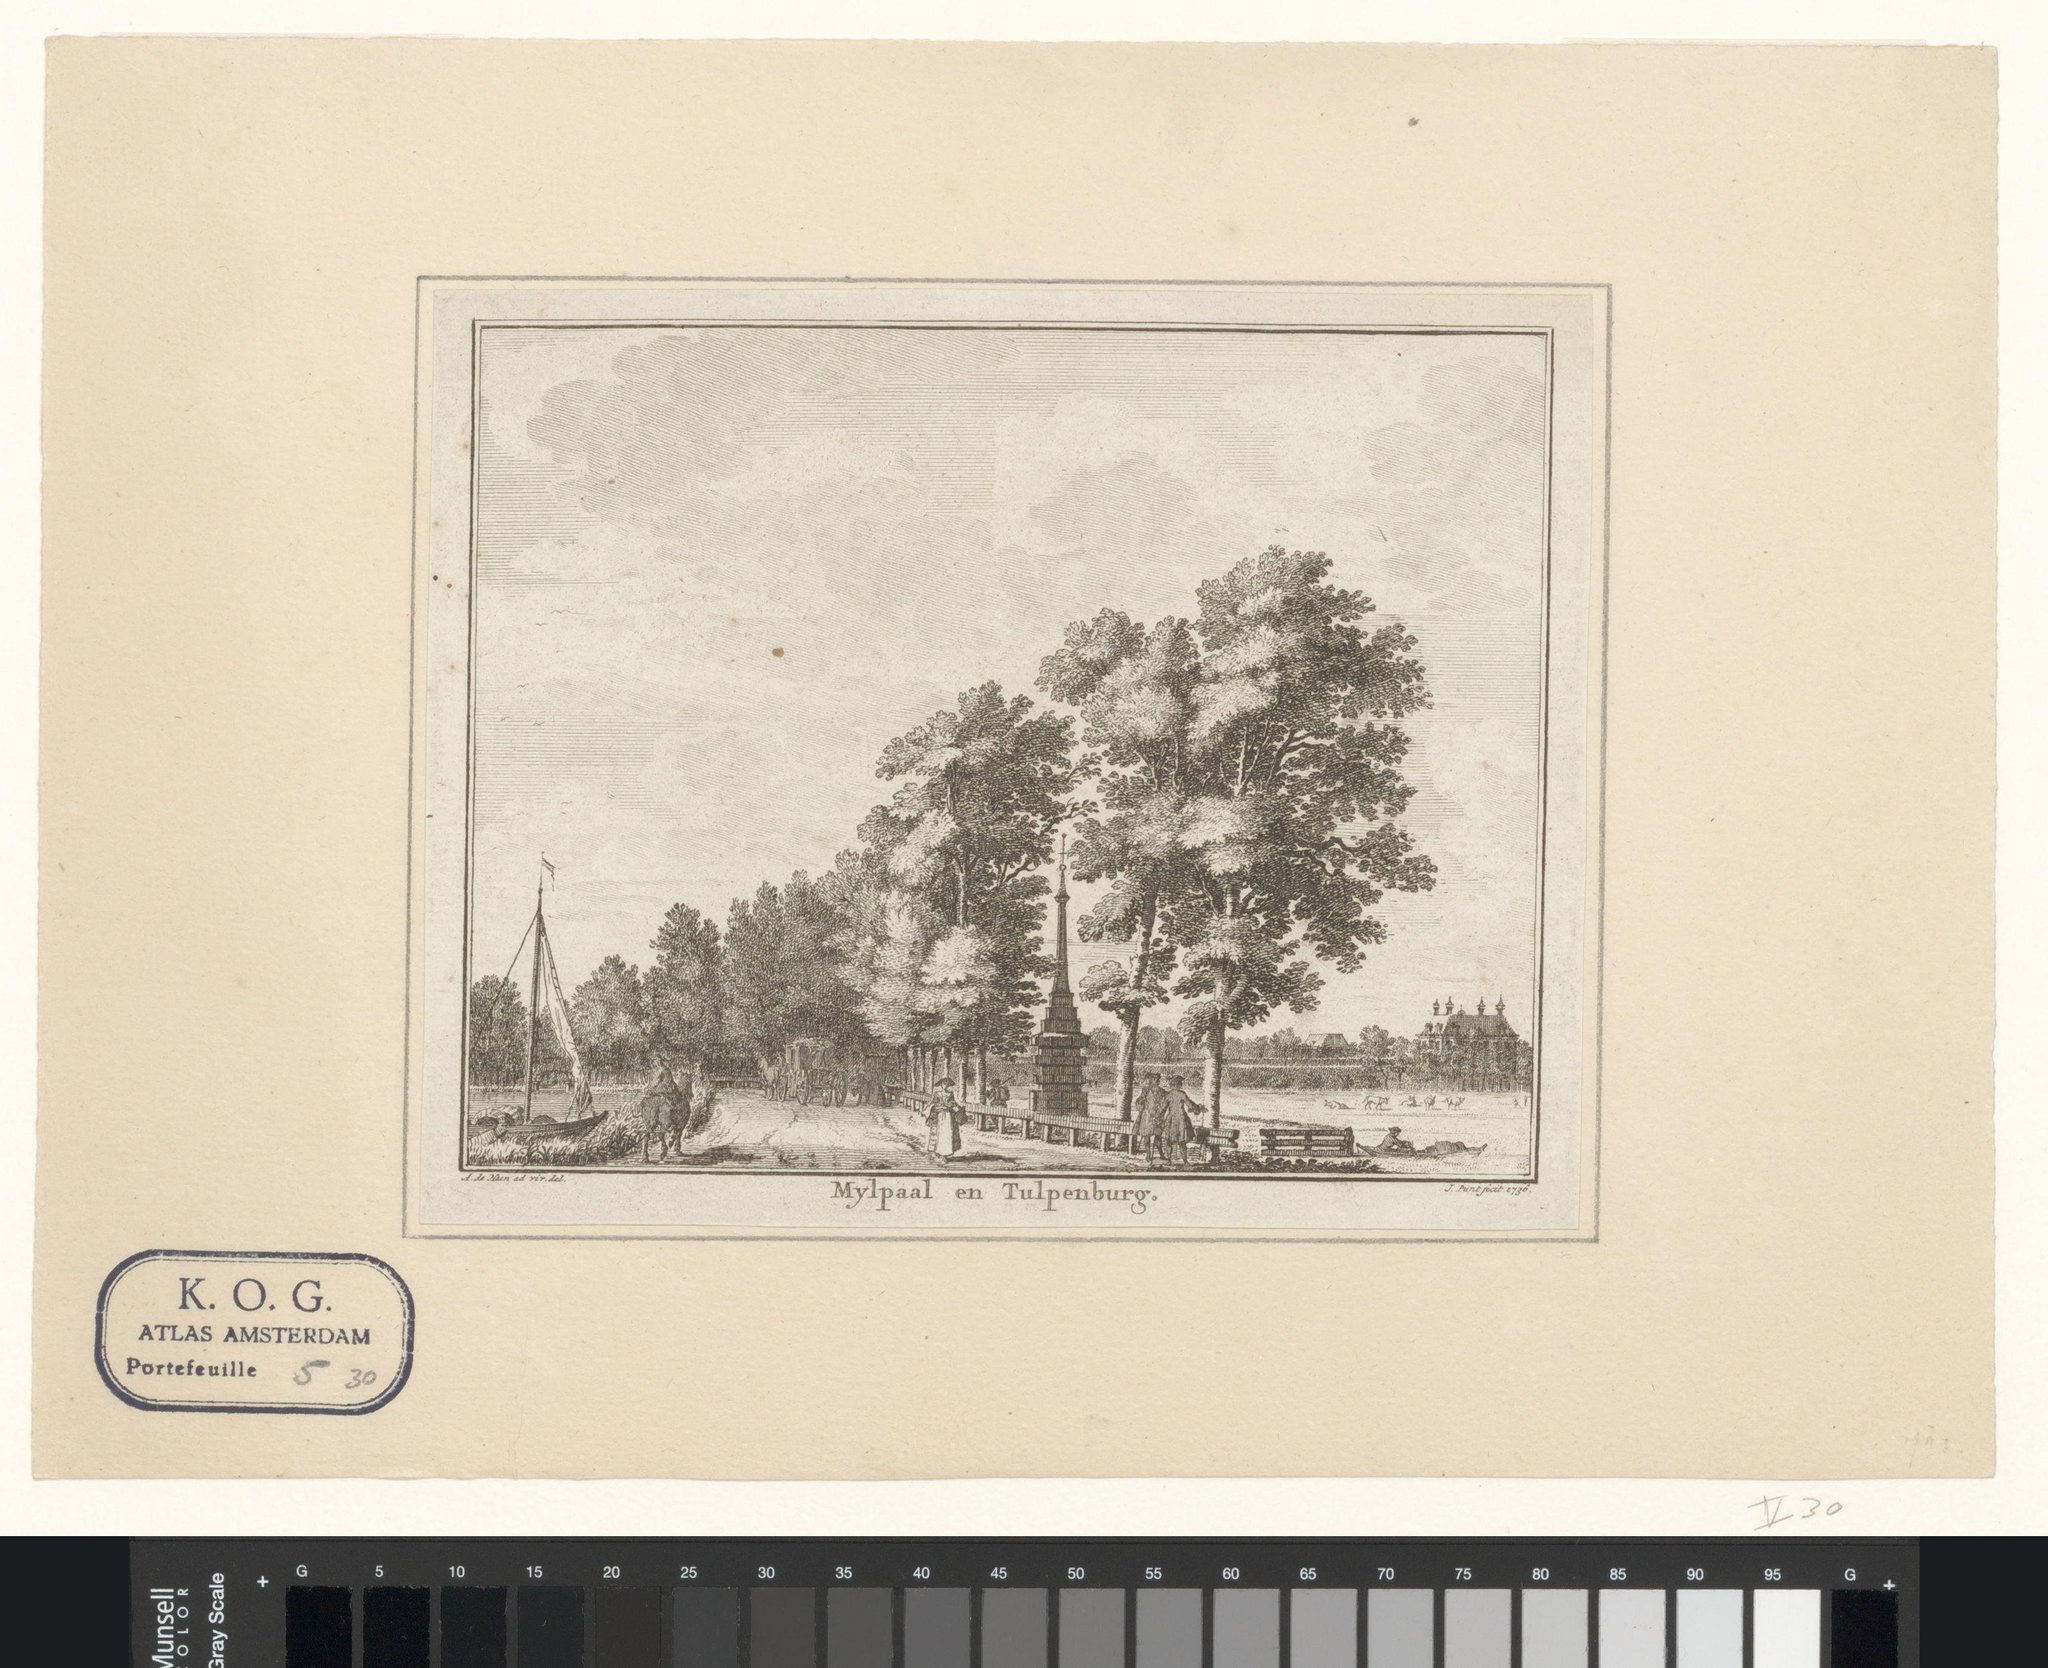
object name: print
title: Mylpaal en Tulpenburg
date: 1736-1773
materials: paper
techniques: engraving, etching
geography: amstelveen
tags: city-view in general; 'veduta', river, rural housing, e.g. country-house, villa, cottage, milestone, boat propelled by man or animal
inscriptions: collector's mark: ‘5 30’ Lugt 1641b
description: Prent ook gebruikt in: Schoemaker, Gerrit ed. Daniel Willinks Amstellandsche Arkadia, of beschryving van de gelegenheit, toestant en gebeurtenissen van Amstellandt, met deszelfs onderhoorige dorpen, heerlykheden, ambachten, lusthoven, wateren, enz. (…). 2 delen. 1e druk. Amsterdam: Arend van Huyssteen, 1737, dl. 1, p. 104. Of in: Schoemaker, Gerrit ed. Daniel Willinks Amstellandsche Arkadia, of beschryving van de gelegenheit, toestant en gebeurtenissen van Amstellandt, met deszelfs onderhoorige dorpen, heerlykheden, ambachten, lusthoven, wateren, enz. (…). 2 delen. 2e druk. Utrecht: Samuel de Waal, 1773, dl. 1, p. 101.